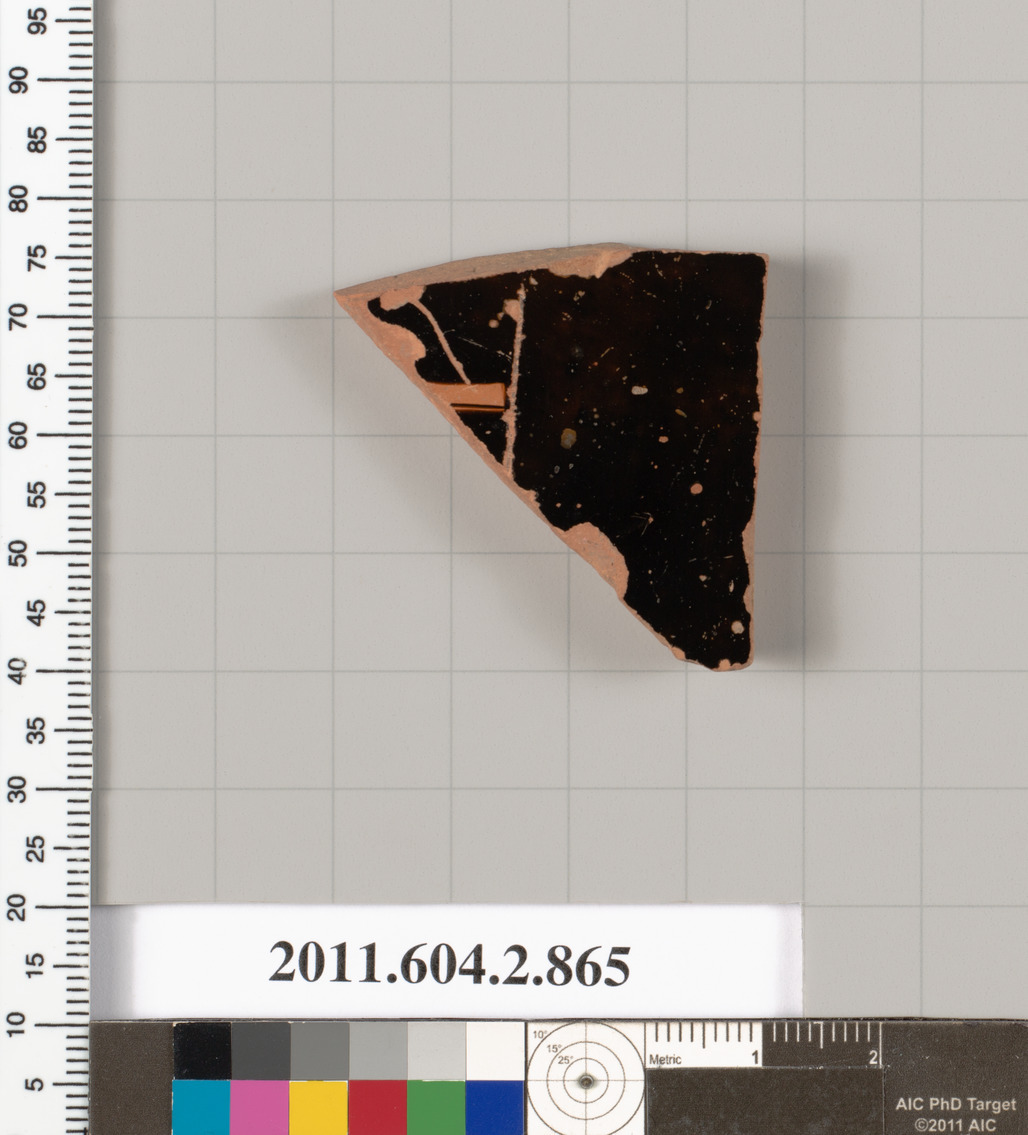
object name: bell krater fragment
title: Terracotta fragment of a bell-krater (bowl for mixing wine and water)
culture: greek, attic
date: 467-435 BCE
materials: terracotta